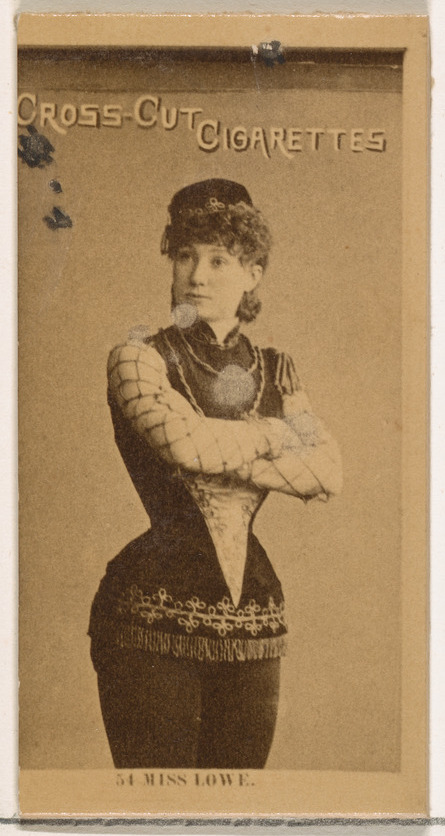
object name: print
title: Card Number 54, Miss Lowe, from the Actors and Actresses series (N145-2) issued by Duke Sons & Co. to promote Cross Cut Cigarettes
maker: w. duke, sons & co.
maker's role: publisher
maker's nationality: american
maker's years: 1870-1920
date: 1880-1889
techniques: albumen silver print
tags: portraits,women,actresses